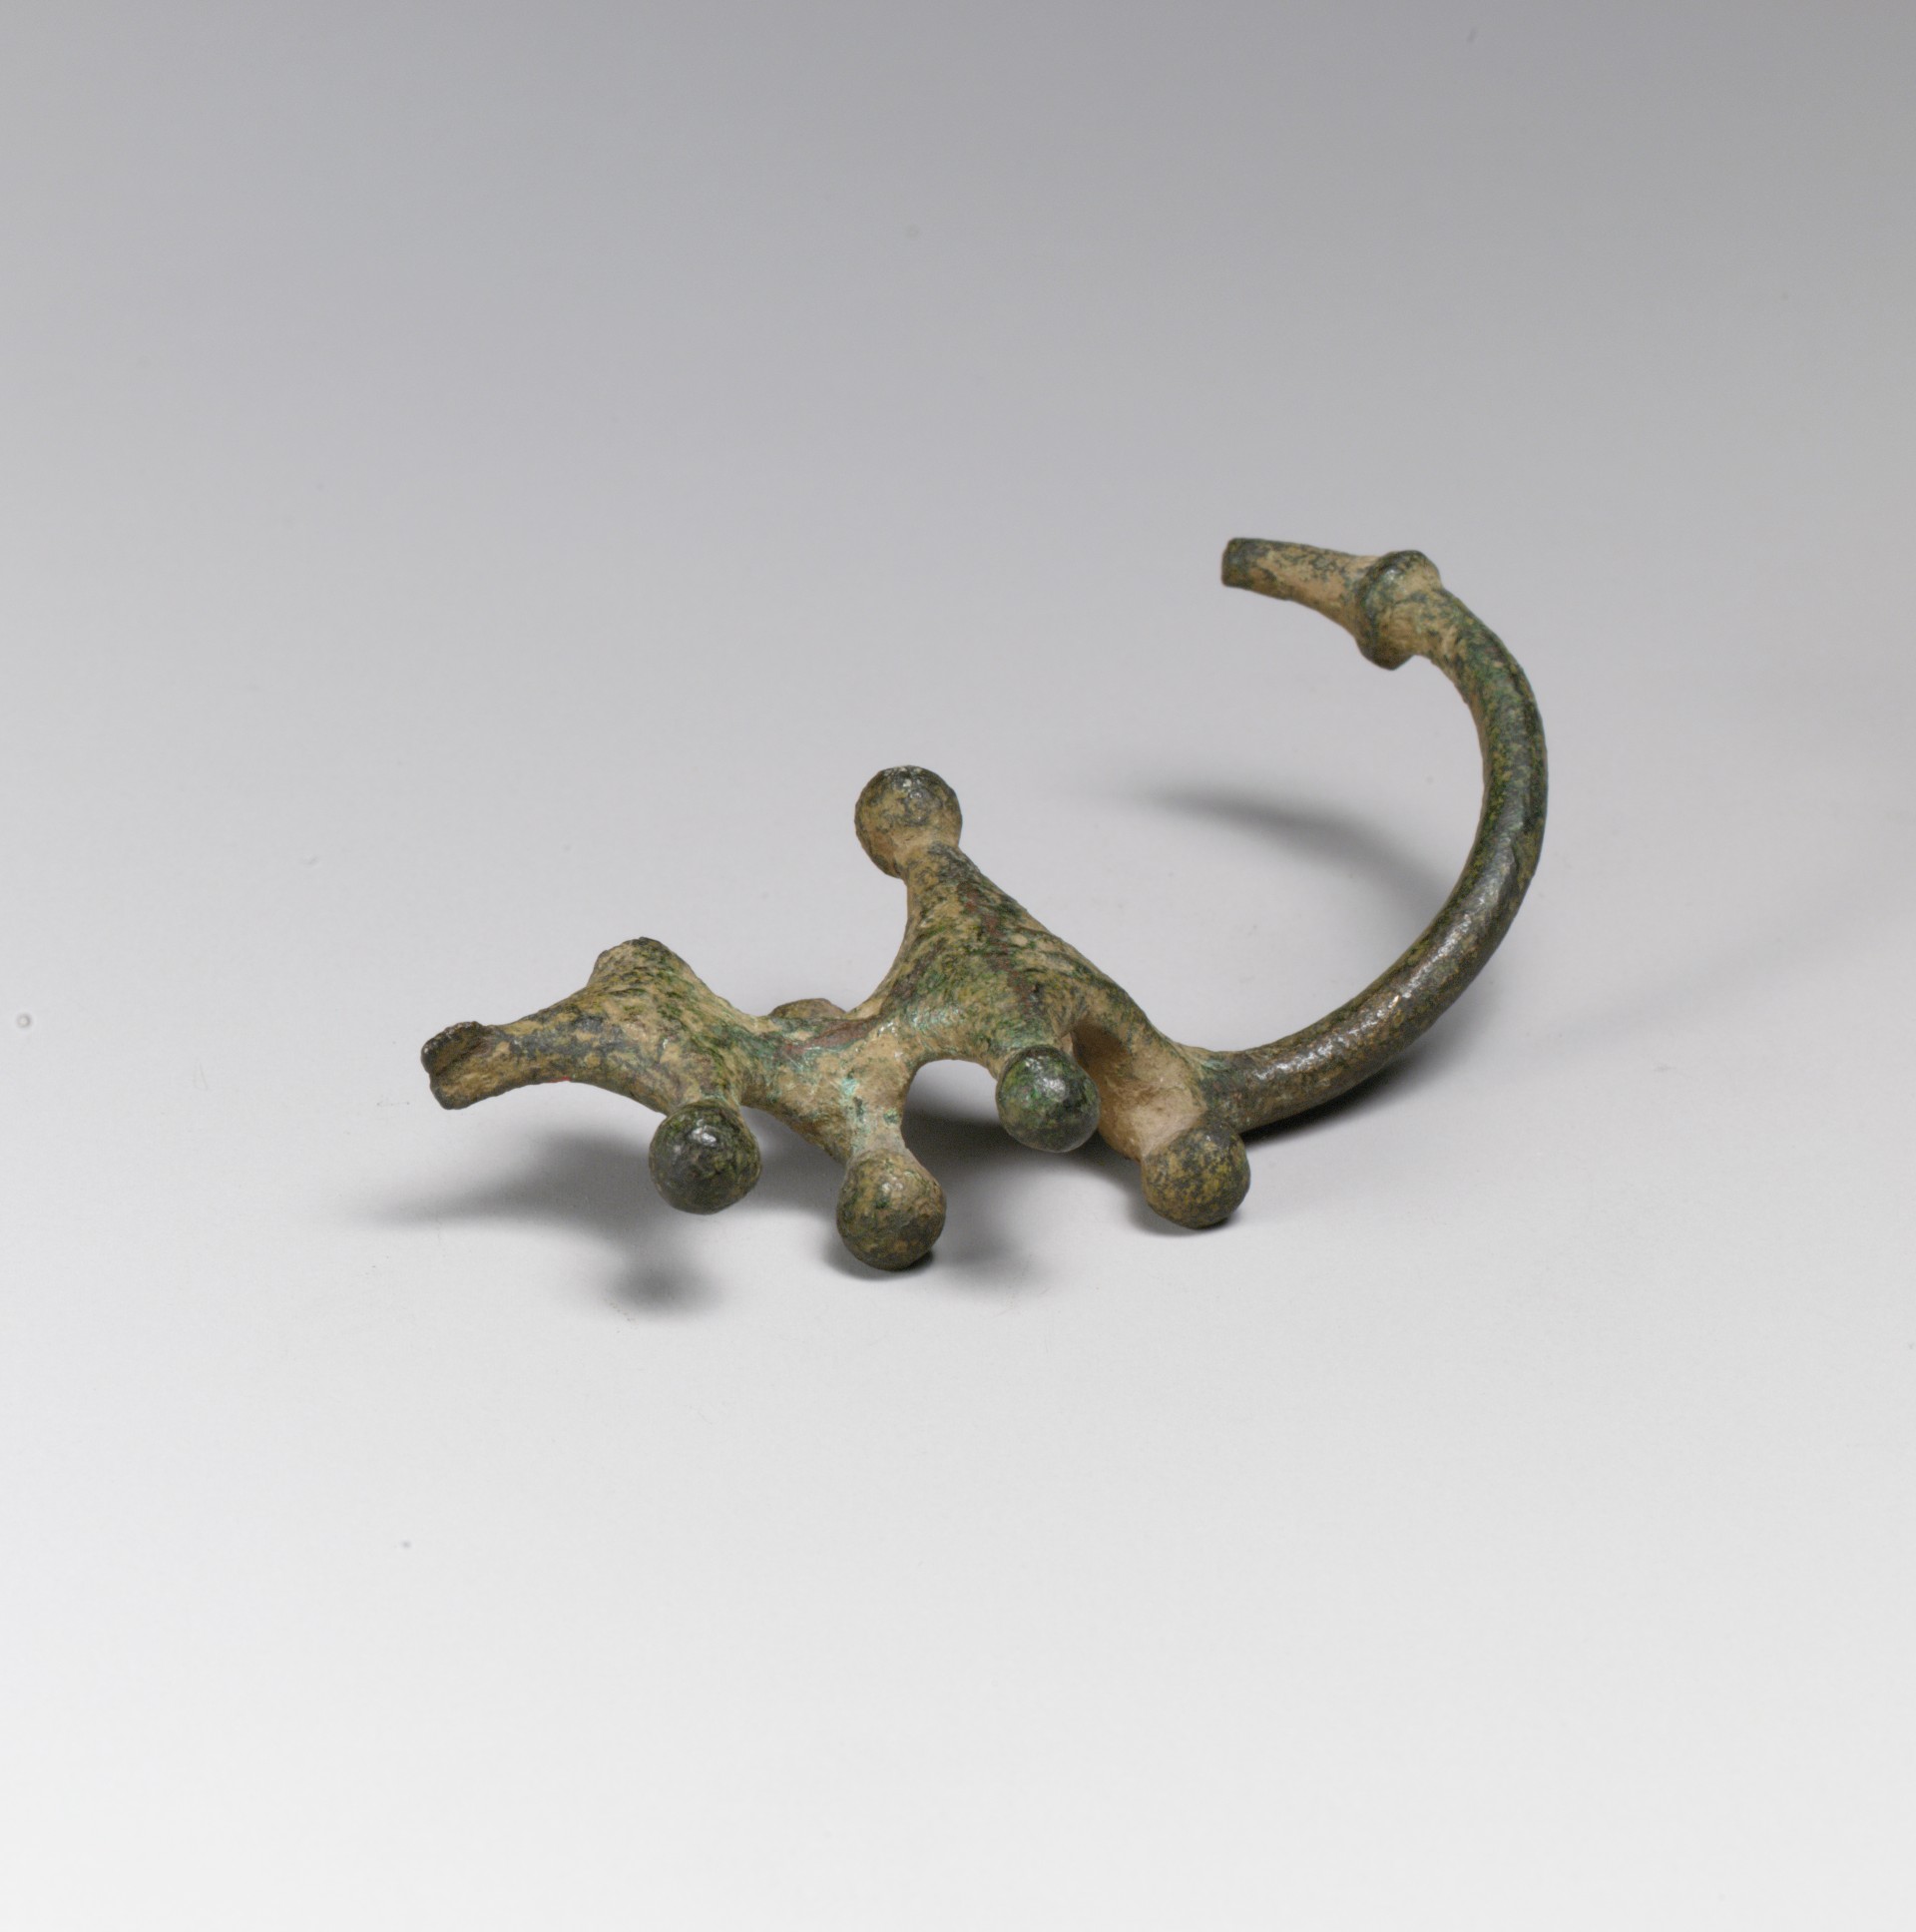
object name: fibula, serpentine type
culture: italic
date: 700-601 BCE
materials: bronze